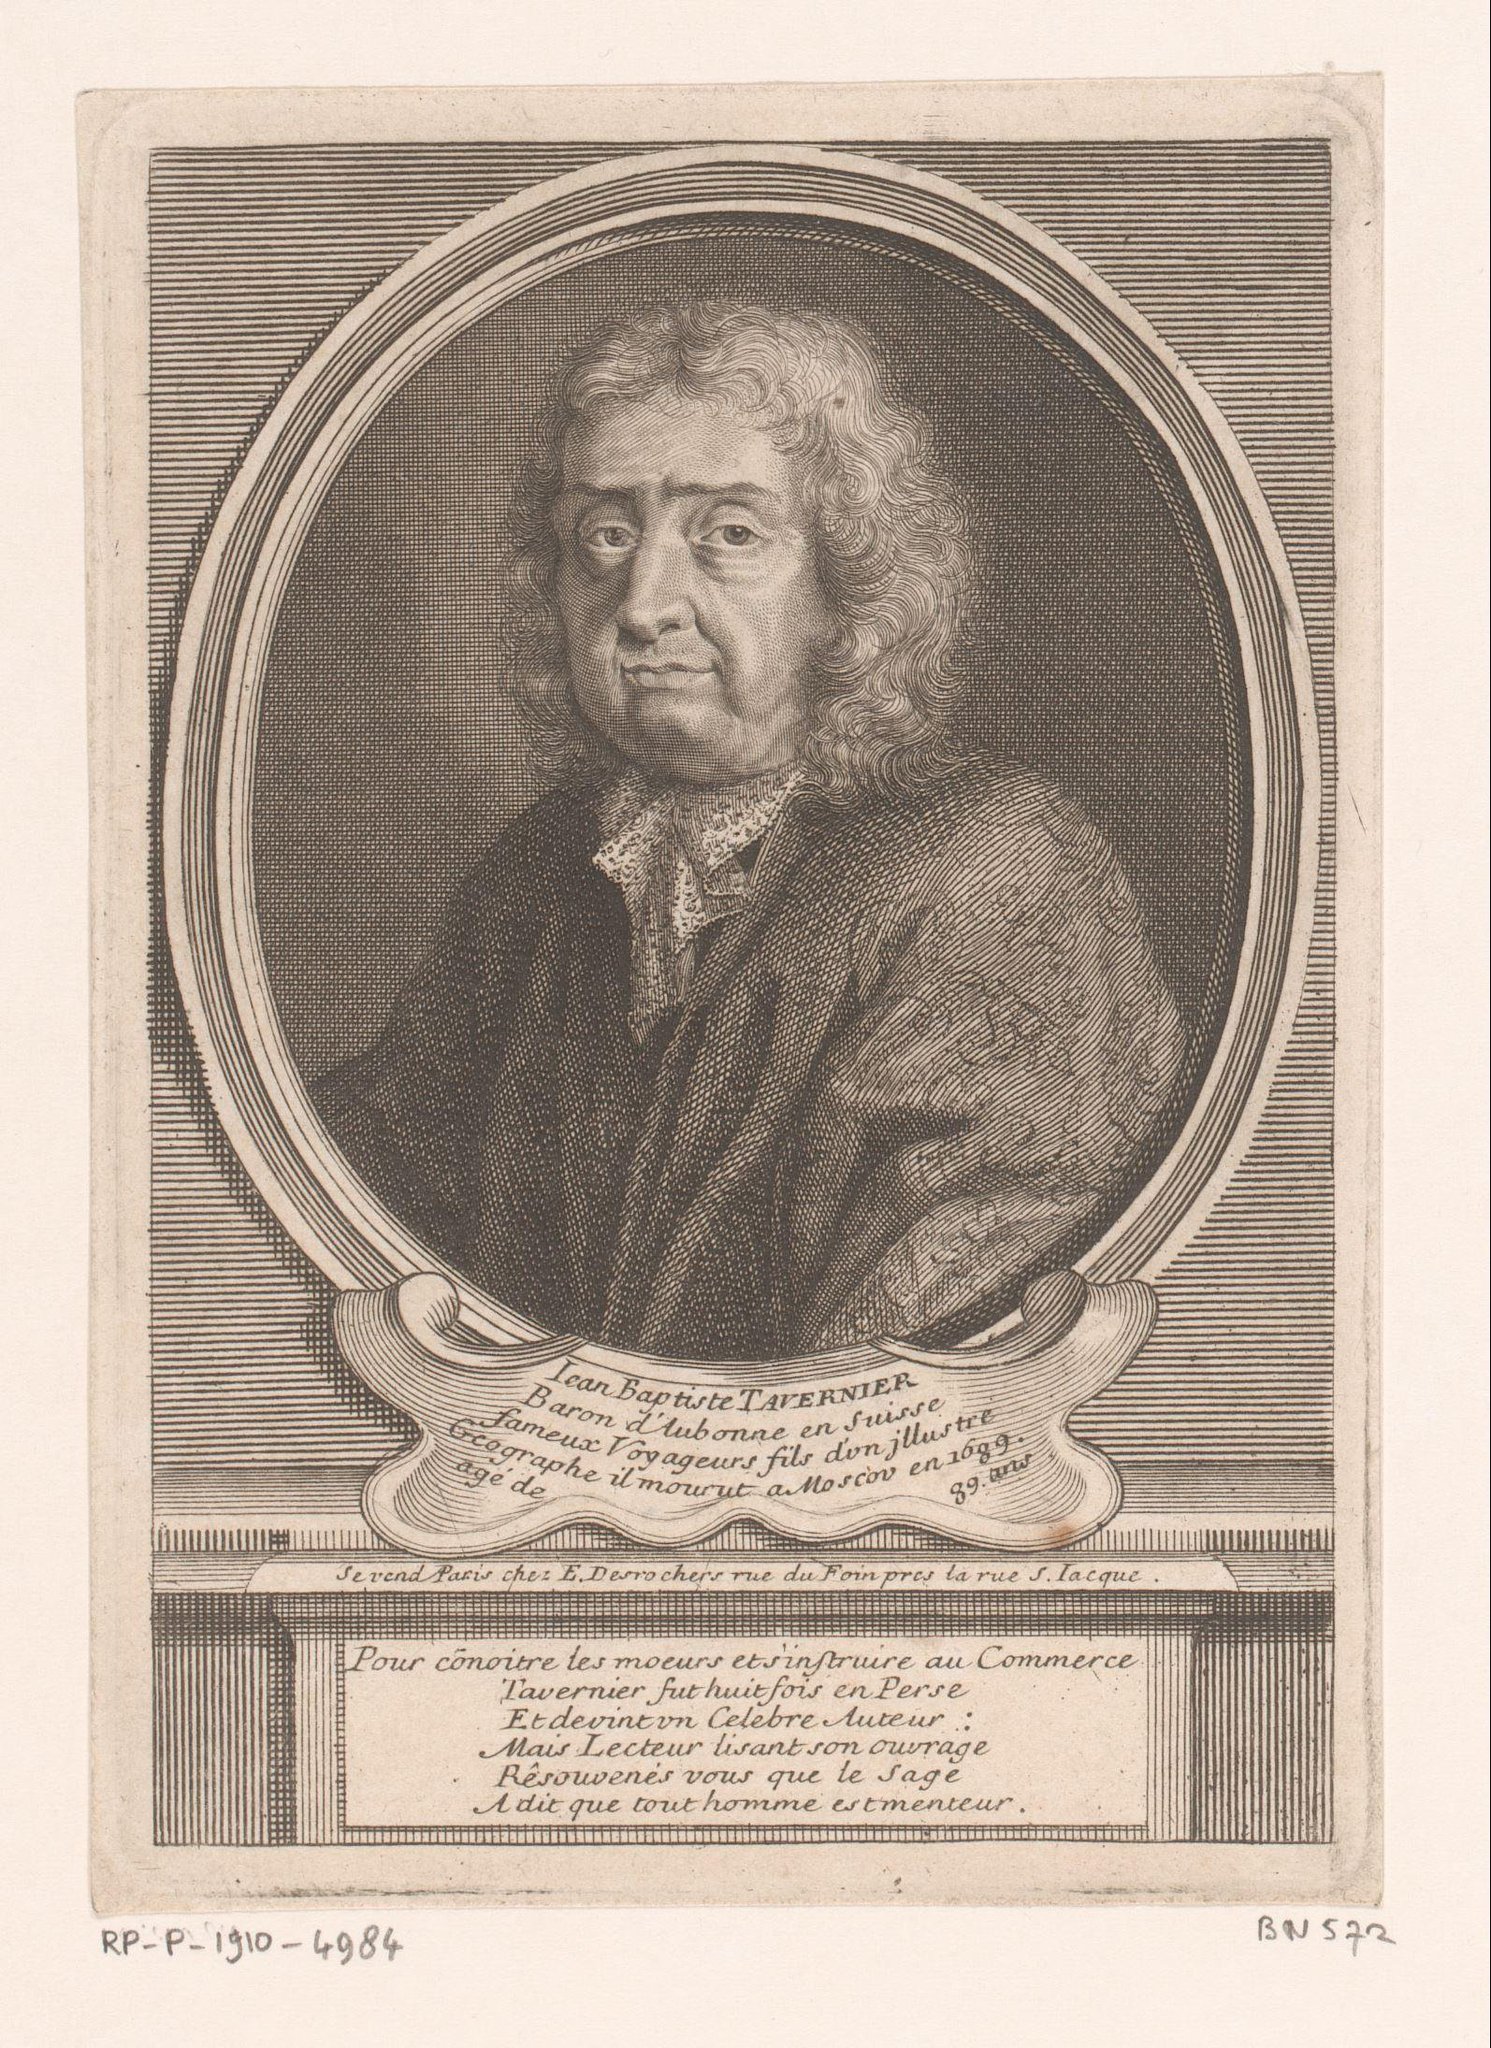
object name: print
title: Verzameling portretten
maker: étienne desrochers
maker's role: print maker, publisher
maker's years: 1668-1741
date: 1726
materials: paper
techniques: engraving, etching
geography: paris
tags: paris, traveler, historical persons, jeweller, goldsmith, silversmith, explorer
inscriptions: collector's mark: Lugt 2228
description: Behoort waarschijnlijk tot een serie portretten, grotendeels door Etienne Desrochers, getiteld: 'Recueil de portraits de personnes qui se sont distinguées tant dans les Armes que dans Belles-Lettres et les Arts, comme aussi la famille royale de France et autres cours étrangères'. De serie werd initieel uitgegeven door Desrochers en aangekondigd in 'Mercure' in mei 1726, p. 985. Echter was Desrochers reeds enkele jaren eerder begonnen met het uitgeven van de serie. Na de dood van Desrochers werd de serie voortgezet door Gilles Edme Petit. Een latere staat werd uitgegeven door Jean François Daumont in Parijs.